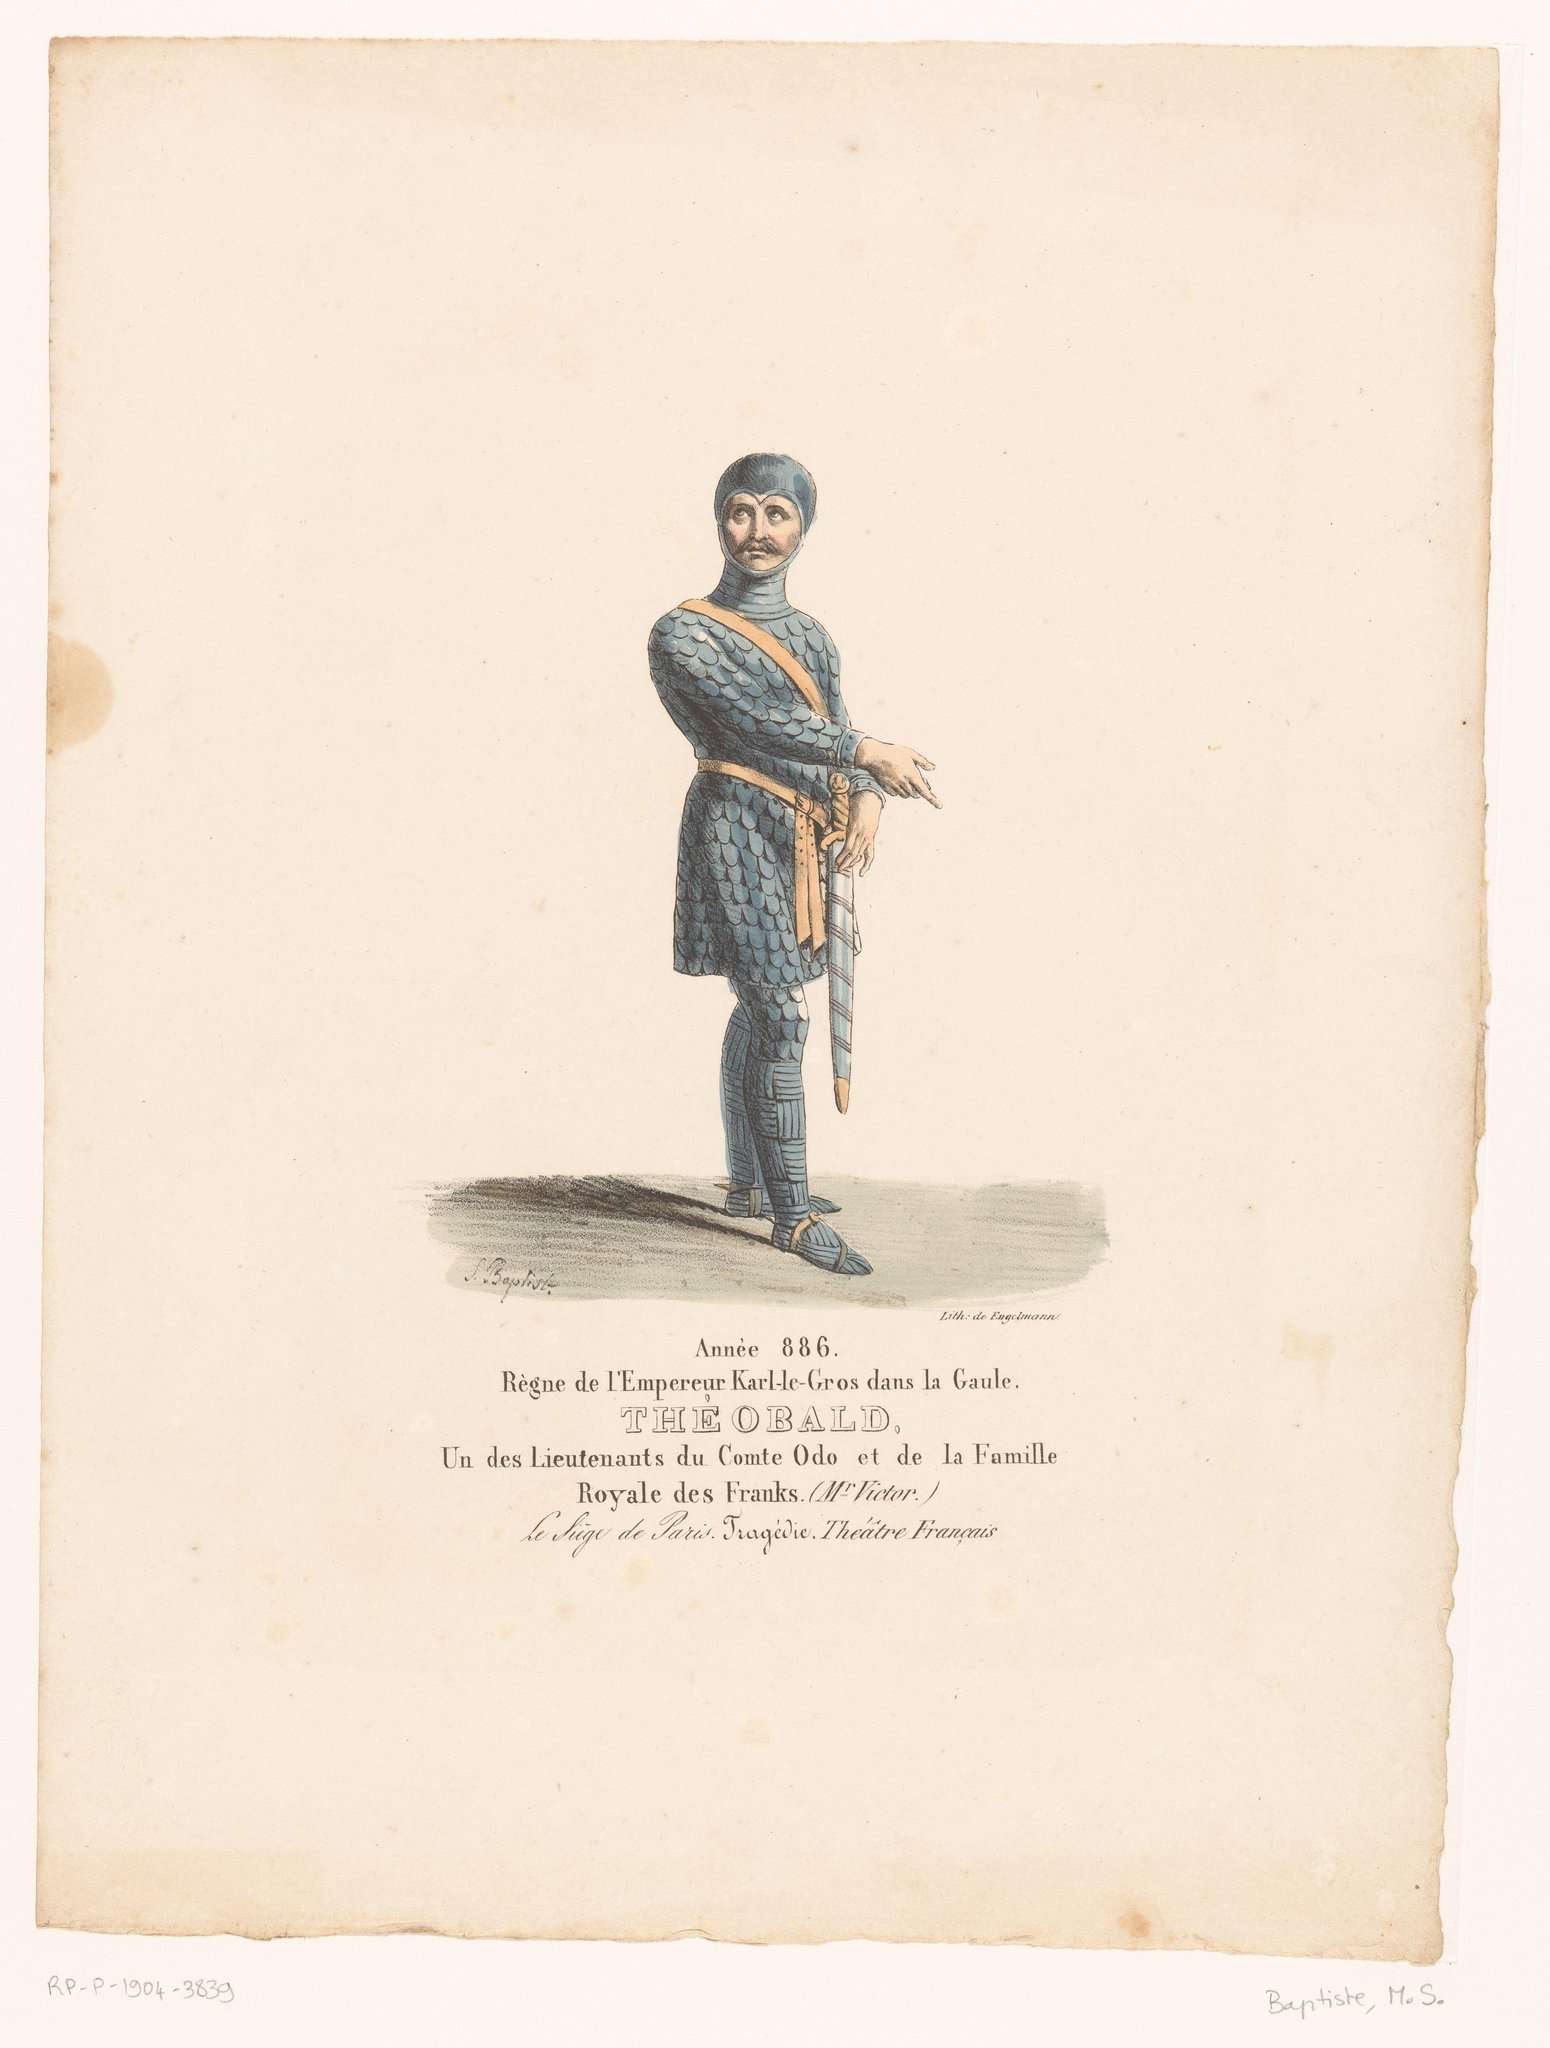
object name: print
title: Théobald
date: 1826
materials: paper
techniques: hand coloring, lithograph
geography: paris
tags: stage costume, actor (on the stage), tragedy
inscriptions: collector's mark: Lugt 2228a